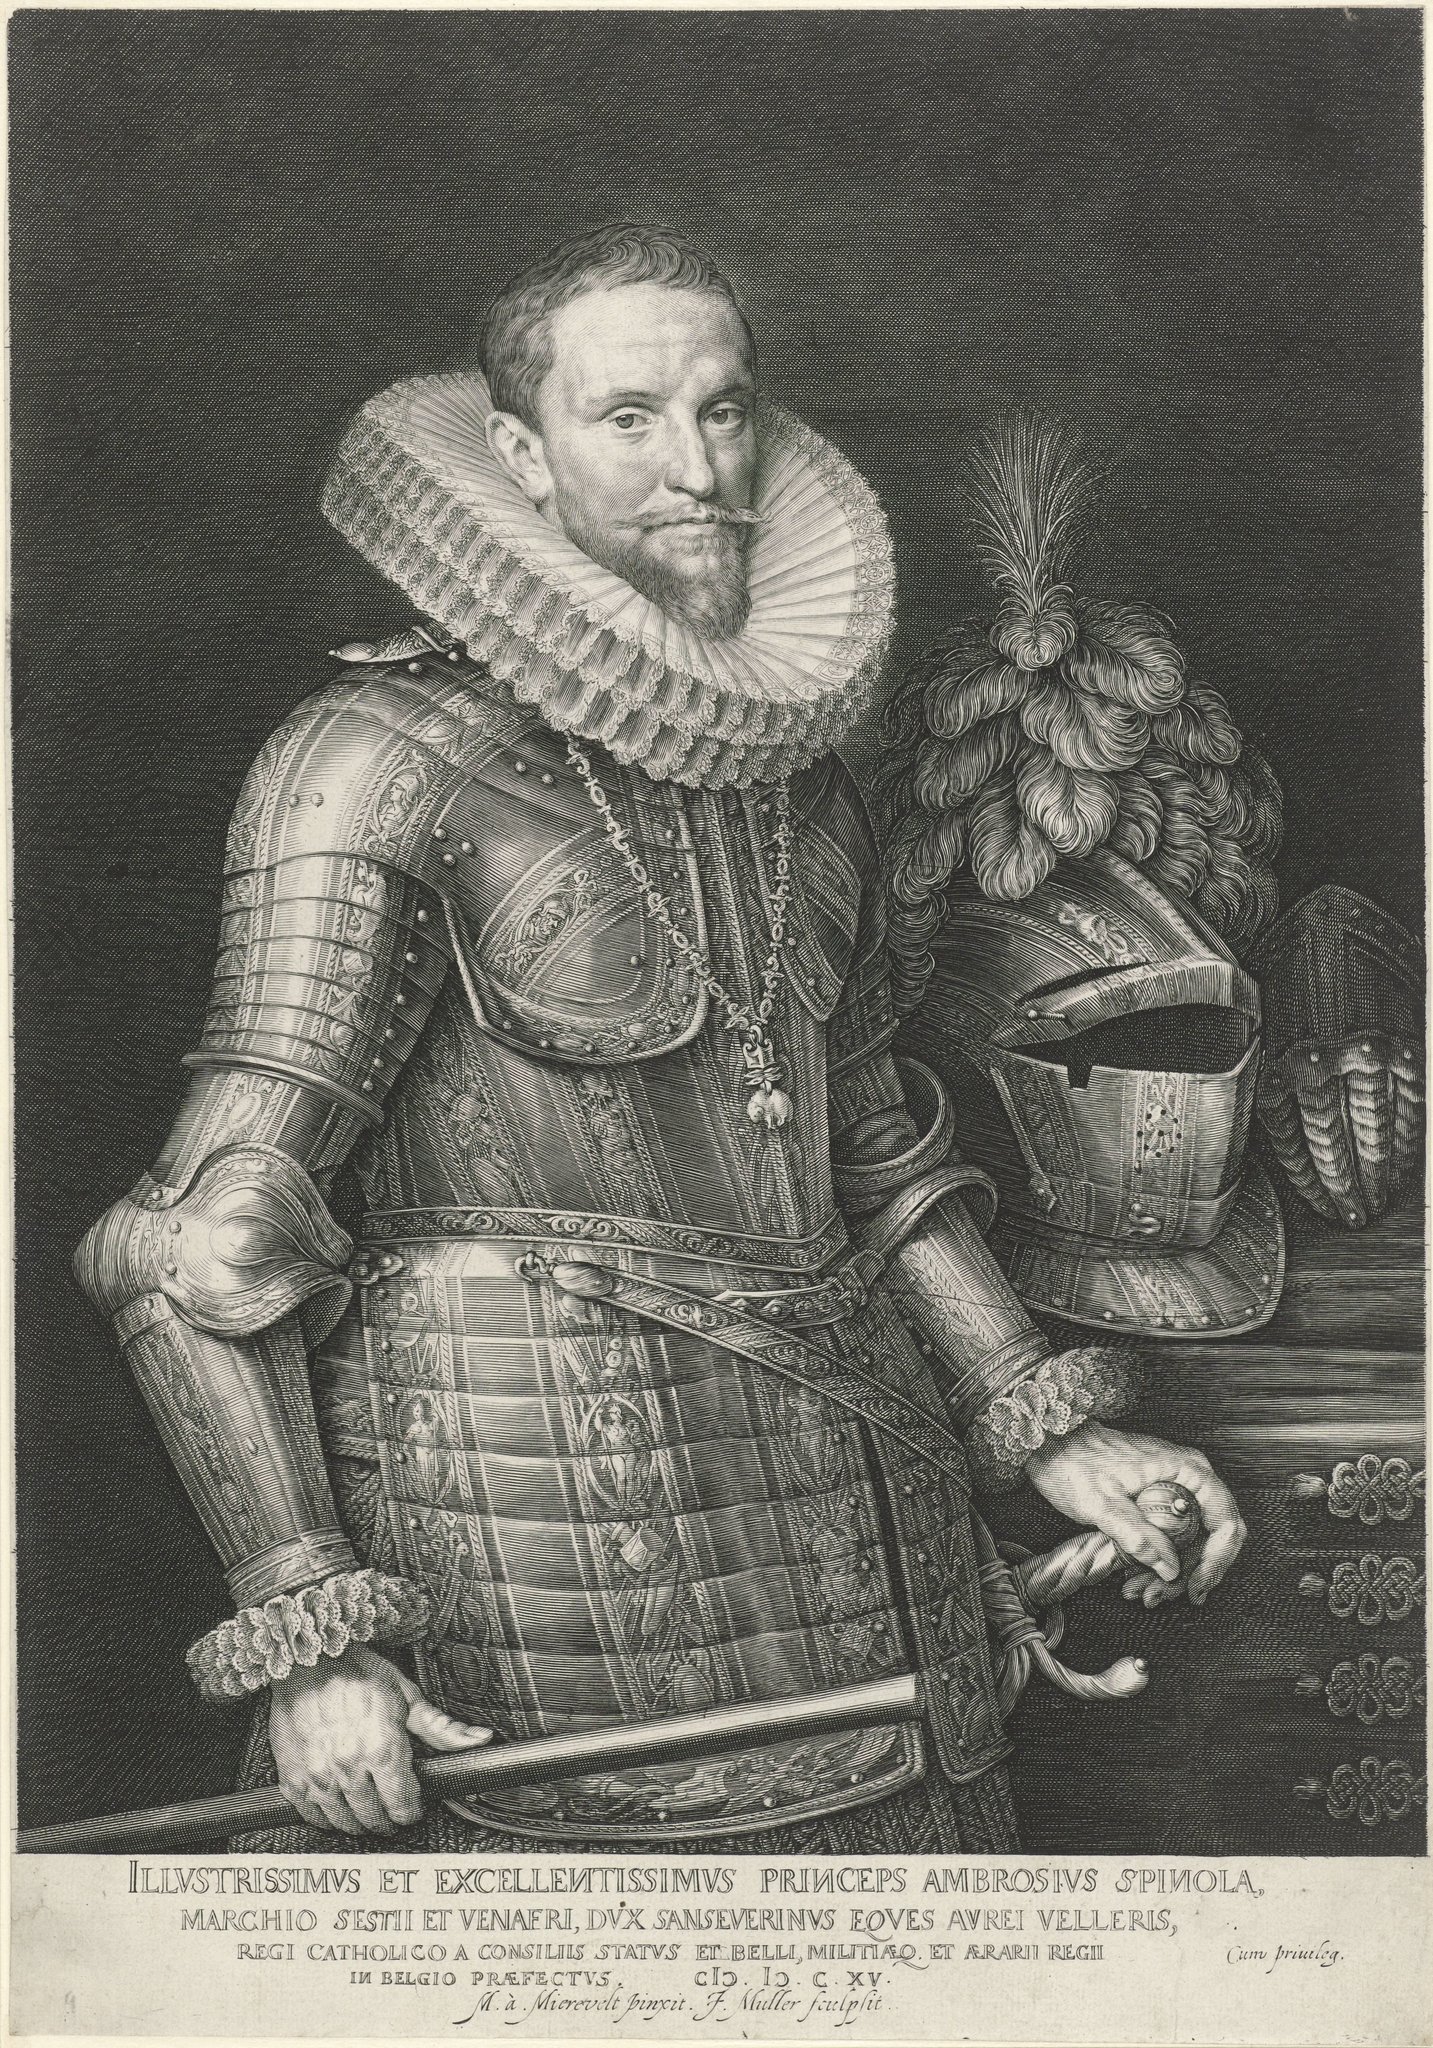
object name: print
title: Portret van Ambrogio Spinola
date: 1615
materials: paper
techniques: engraving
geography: amsterdam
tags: helmet, historical persons, knighthood order of the golden fleece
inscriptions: collector's mark: Lugt 2228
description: Portret van Ambrogio Spinola, markies de los Balbases, gekleed in harnas met een bevelhebbersstaf in zijn hand. Rechts op tafel zijn helm.